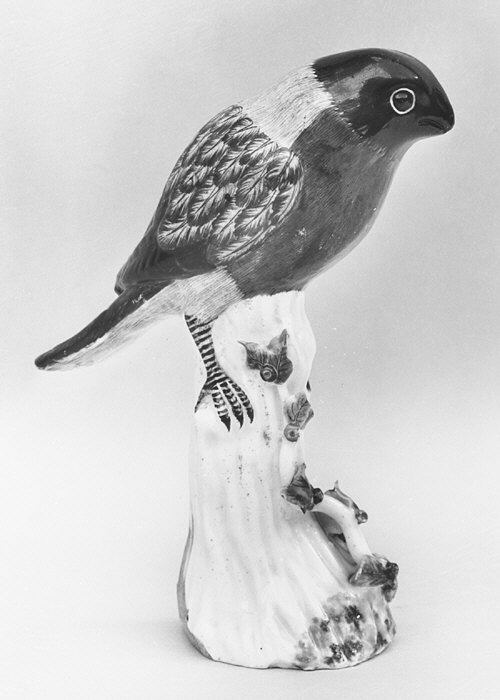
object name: figure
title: Bullfinch (one of a pair)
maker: vincennes manufactory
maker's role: manufactory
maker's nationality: french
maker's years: 1740-1756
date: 1749-1750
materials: soft paste porcelain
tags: birds,flowers,leaves